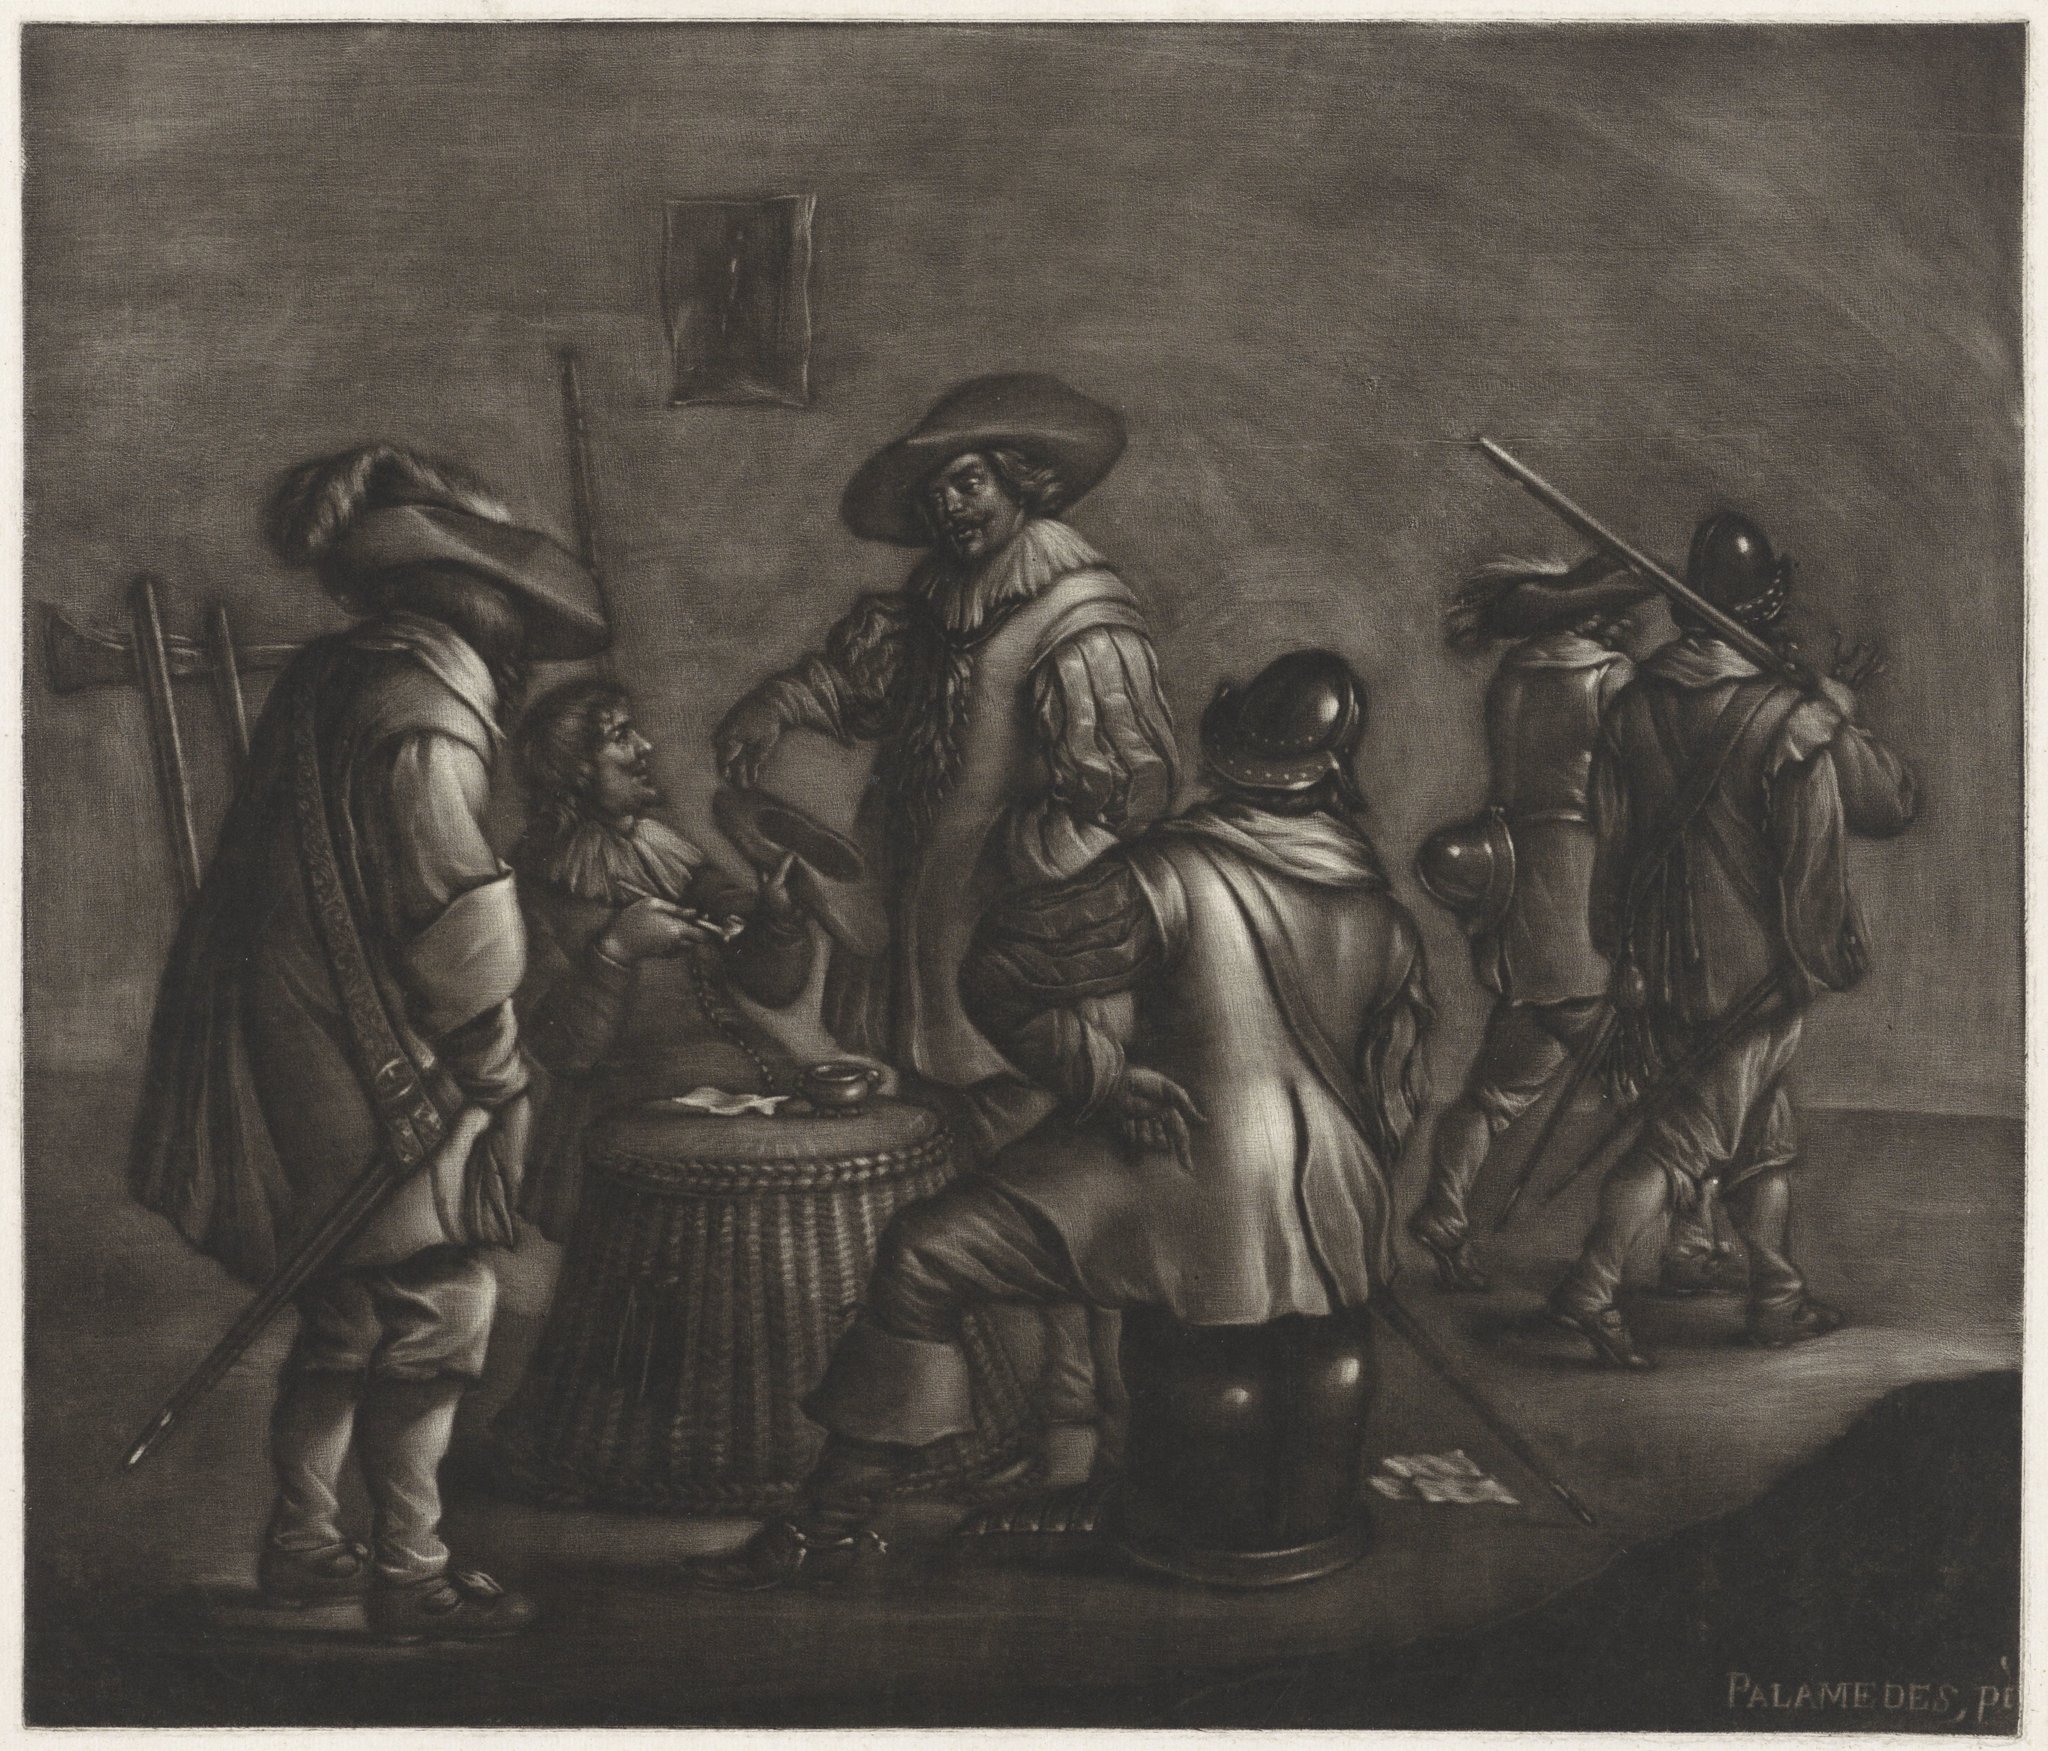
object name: print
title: Soldaten in een herberg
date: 1658-1727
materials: paper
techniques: mezzotint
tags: inn, coffee-house, public house, etc., pipe ~ tobacco, recreation ~ the soldier off duty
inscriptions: collector's mark: Lugt 10, collector's mark: Lugt 11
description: In een herberg zitten vier soldaten te praten en te roken rond een omgekeerde mand. Twee andere soldaten verlaten het vertrek. Aan de muur hangt een prent.